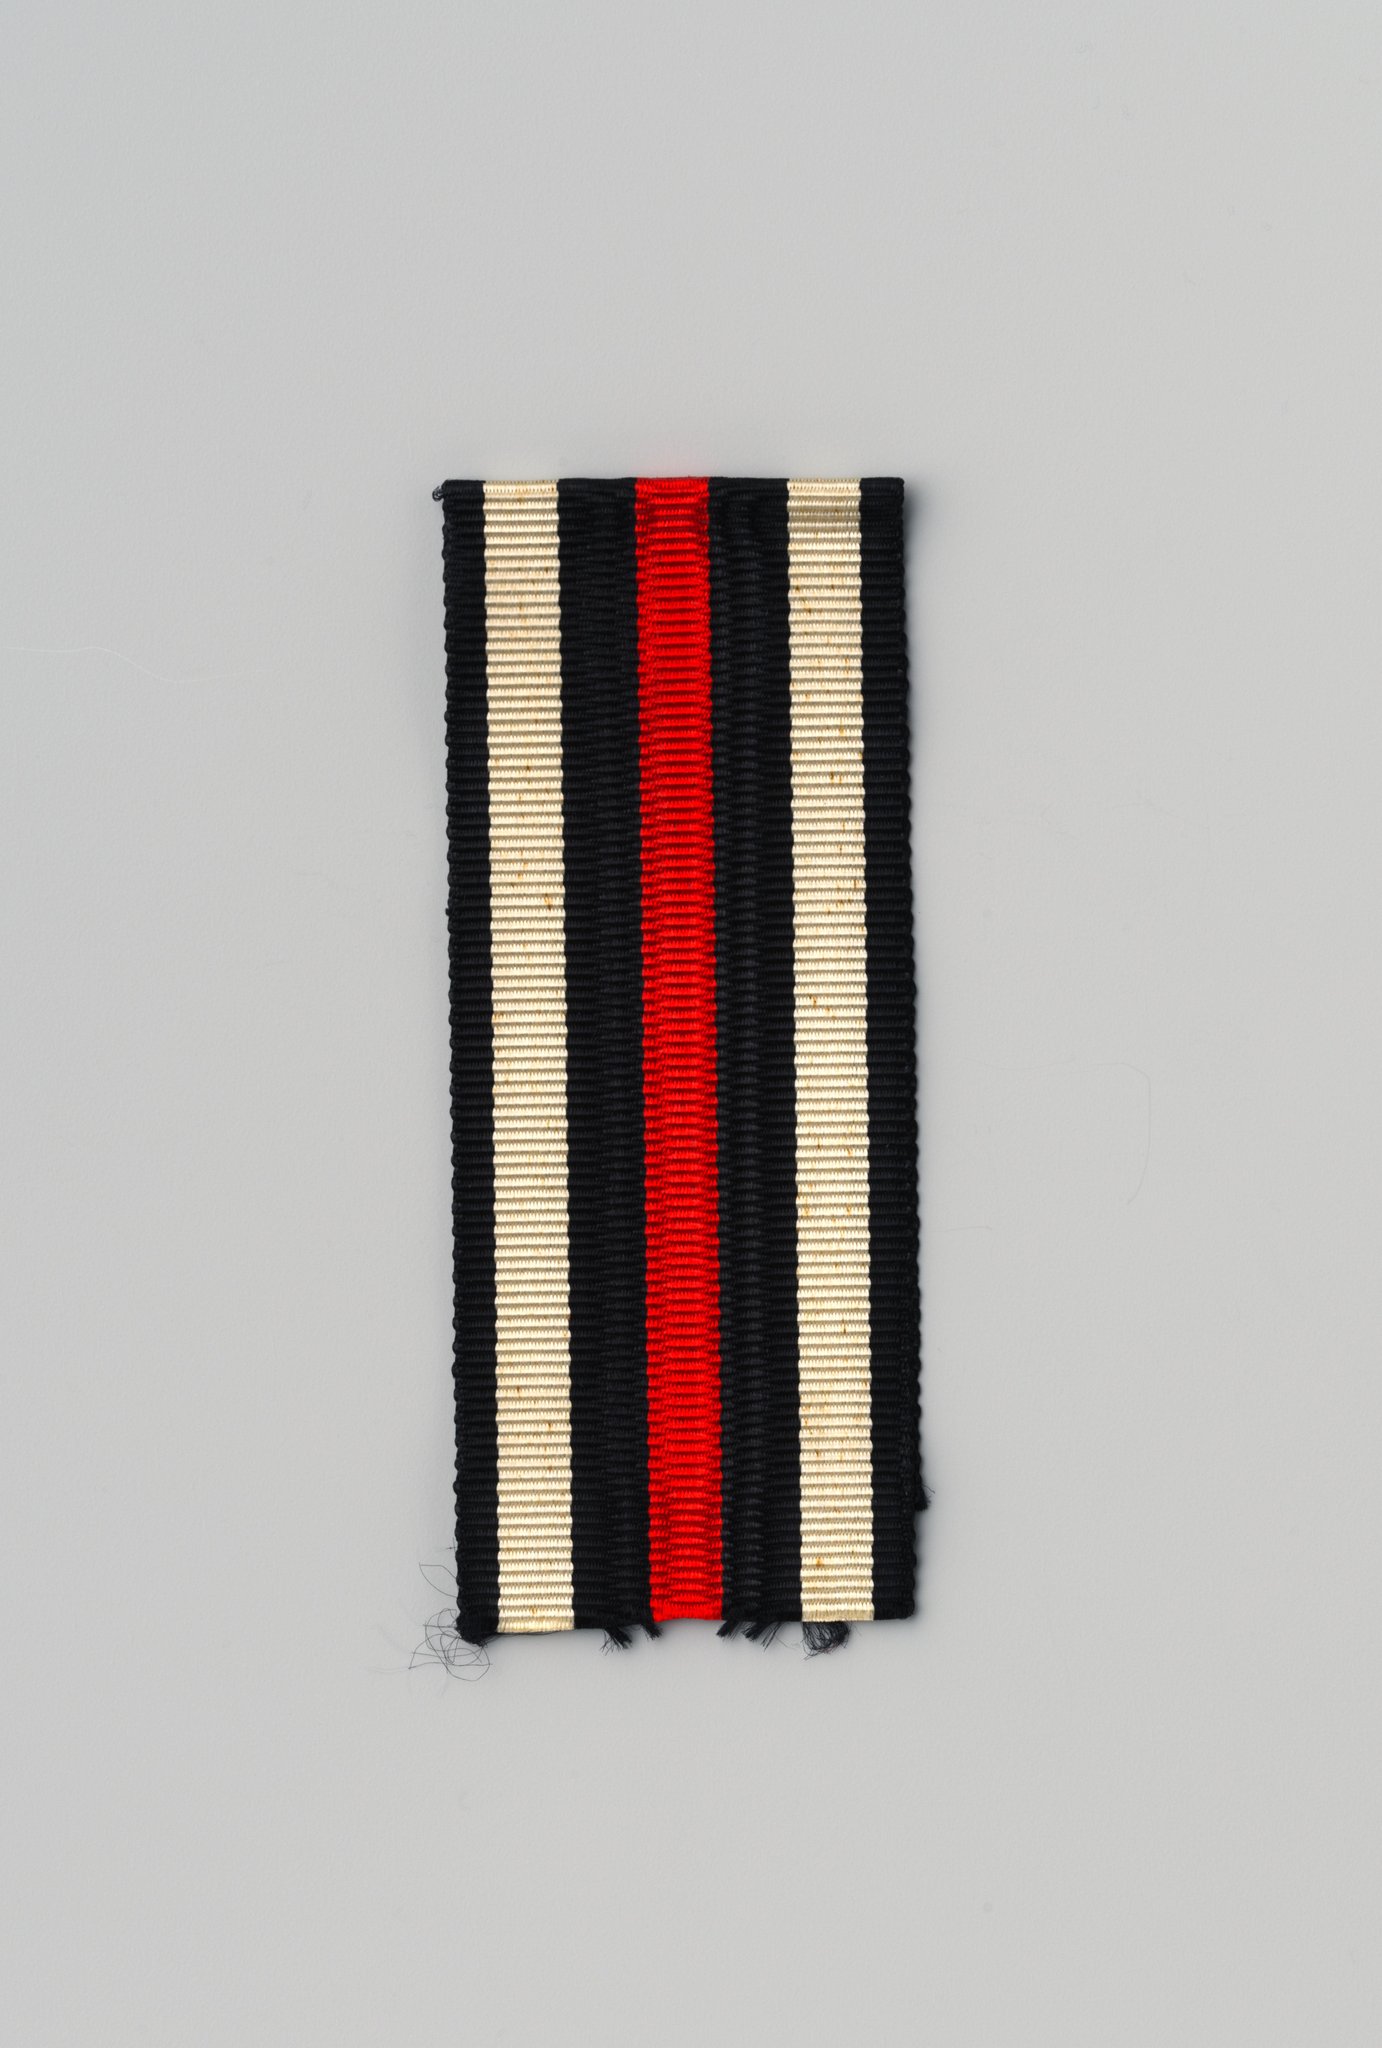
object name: onderscheidingsteken, onderscheiding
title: Lint, zwart-wit-rood gestreept, horend bij een onderscheiding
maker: Anonymous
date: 1900-1925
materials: silk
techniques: weave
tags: eugen wachenheimer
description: Dit object is onderdeel van de nalatenschap van Isabel Elon-Wachenheimer (1928-2010). Tot haar overlijden behoorde het samen met de andere objecten uit de nalatenschap tot haar privédomein van Isabel Wachenheimer. In die particuliere context zijn deze objecten tezamen en individueel aandenkens - aan de jeugd, ouders en familie van Isabel Wachenheimer vóór en tijdens de Shoah en aan haar leven na de Tweede Wereldoorlog. Isabel Wachenheimer, die van juni 1943 tot mei 1945 gevangen zat in Kamp Westerbork, Theresienstadt, Auschwitz, Lenzing a/d Oberdonau (een buitenkamp van Mauthausen), overleefde de Shoah. Haar ouders – Eugène Wachenheimer en Else Wachenheimer-Moos - werden op 14 oktober 1944 in Auschwitz-Birkenau vermoord.